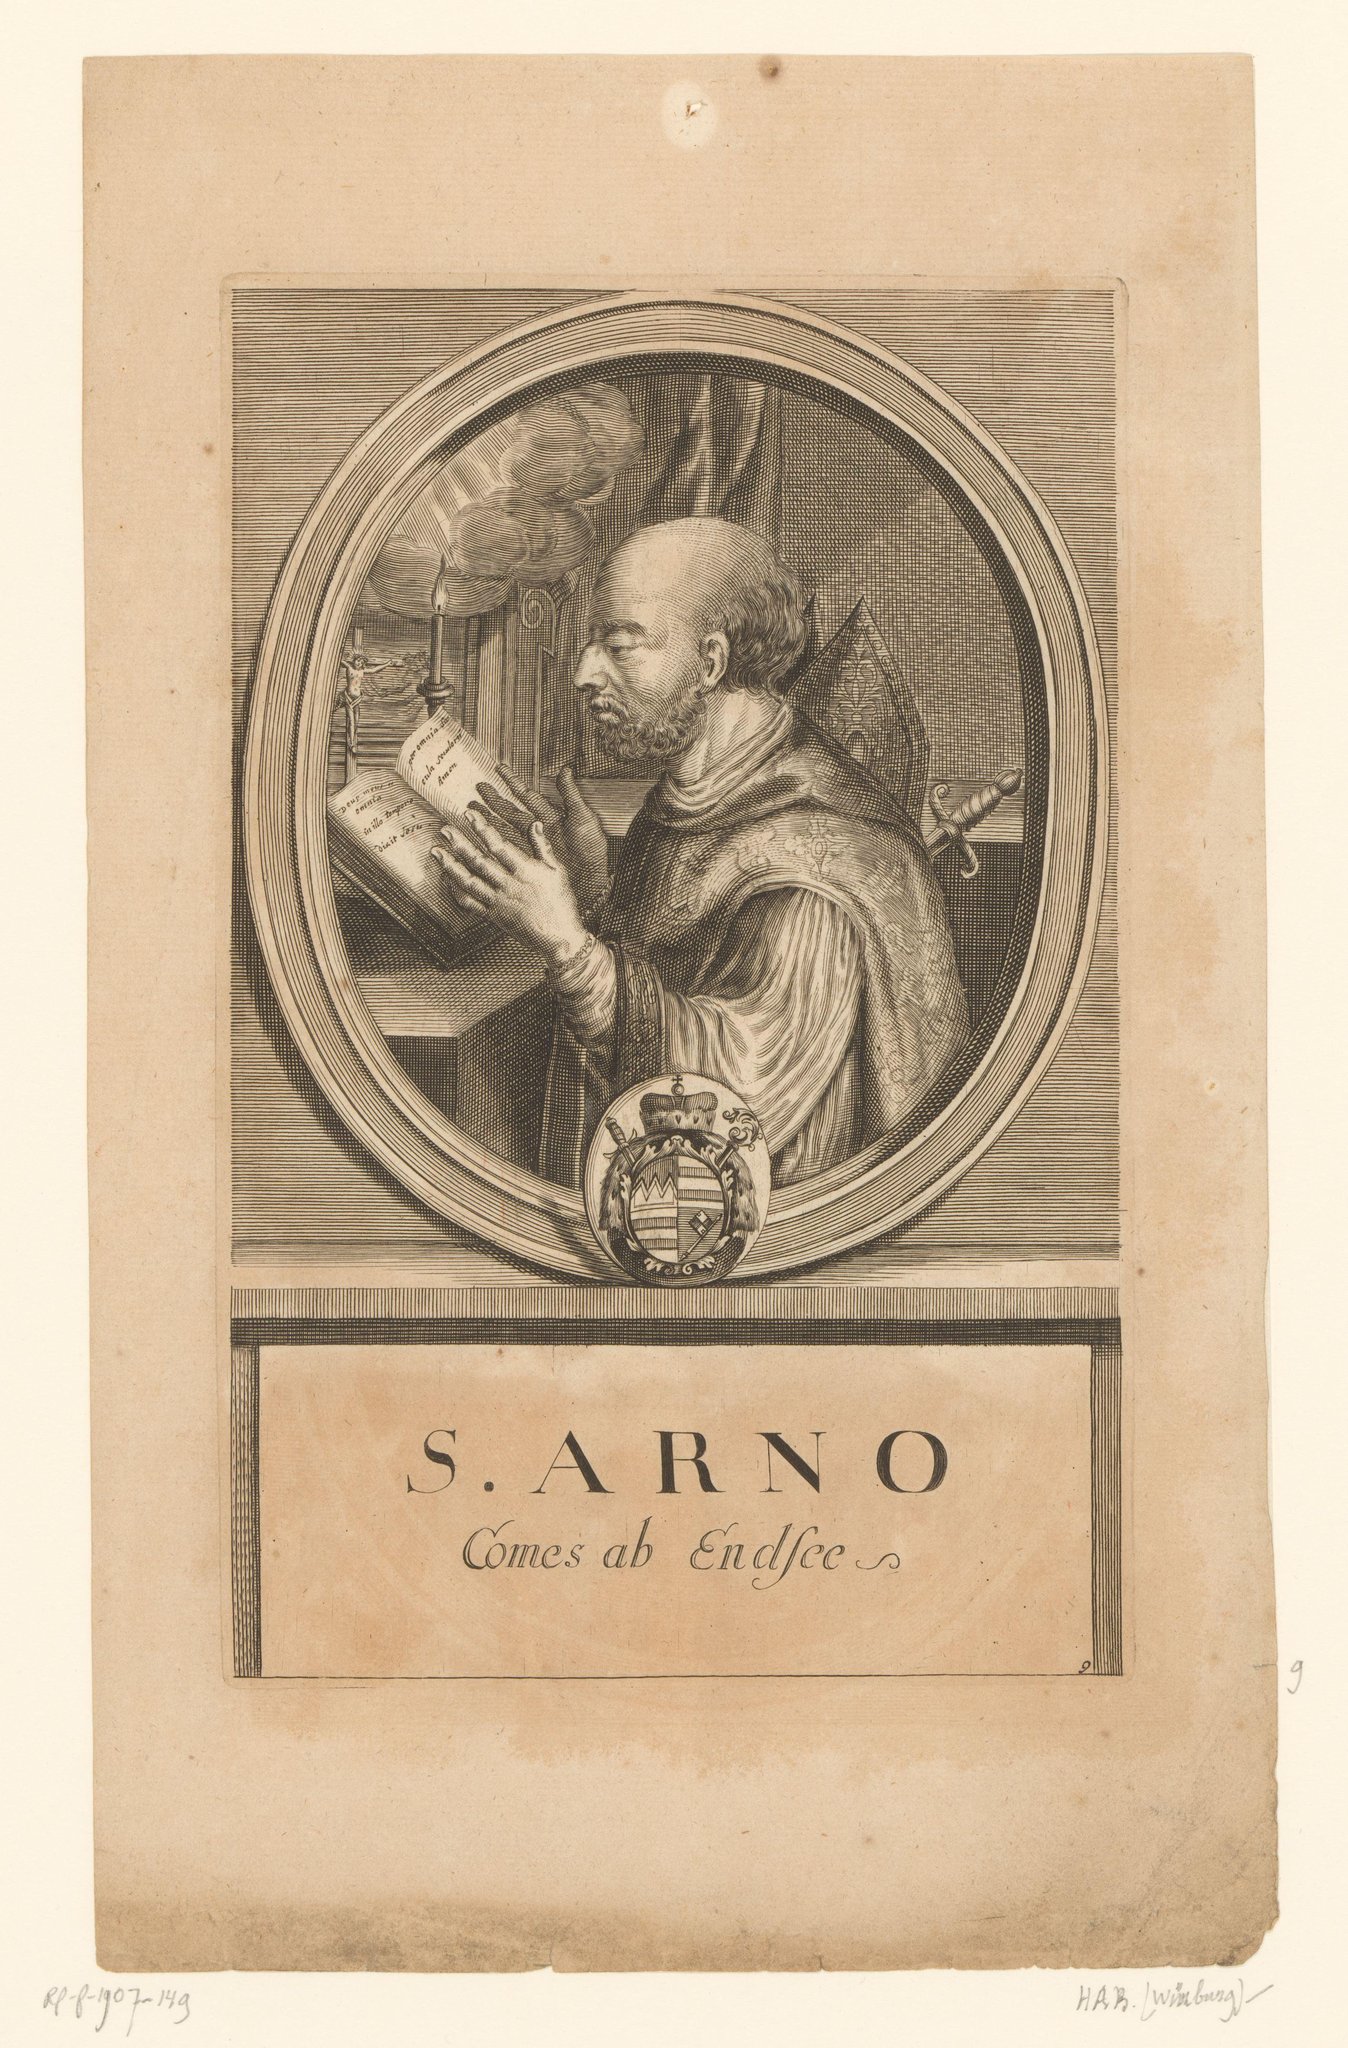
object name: print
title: Portret van Arn van Würzburg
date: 1713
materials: paper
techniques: engraving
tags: archbishop, bishop, etc. (roman catholic), theologian, historical persons, armorial bearing, heraldry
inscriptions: collector's mark: Lugt 2228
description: Prent ook gebruikt in: Ludewig, Johann Peter von. Geschicht-Schreiber von dem Bischoffthum Wirtzburg. Frankfurt am Main: Thomas Fritsch, 1713.